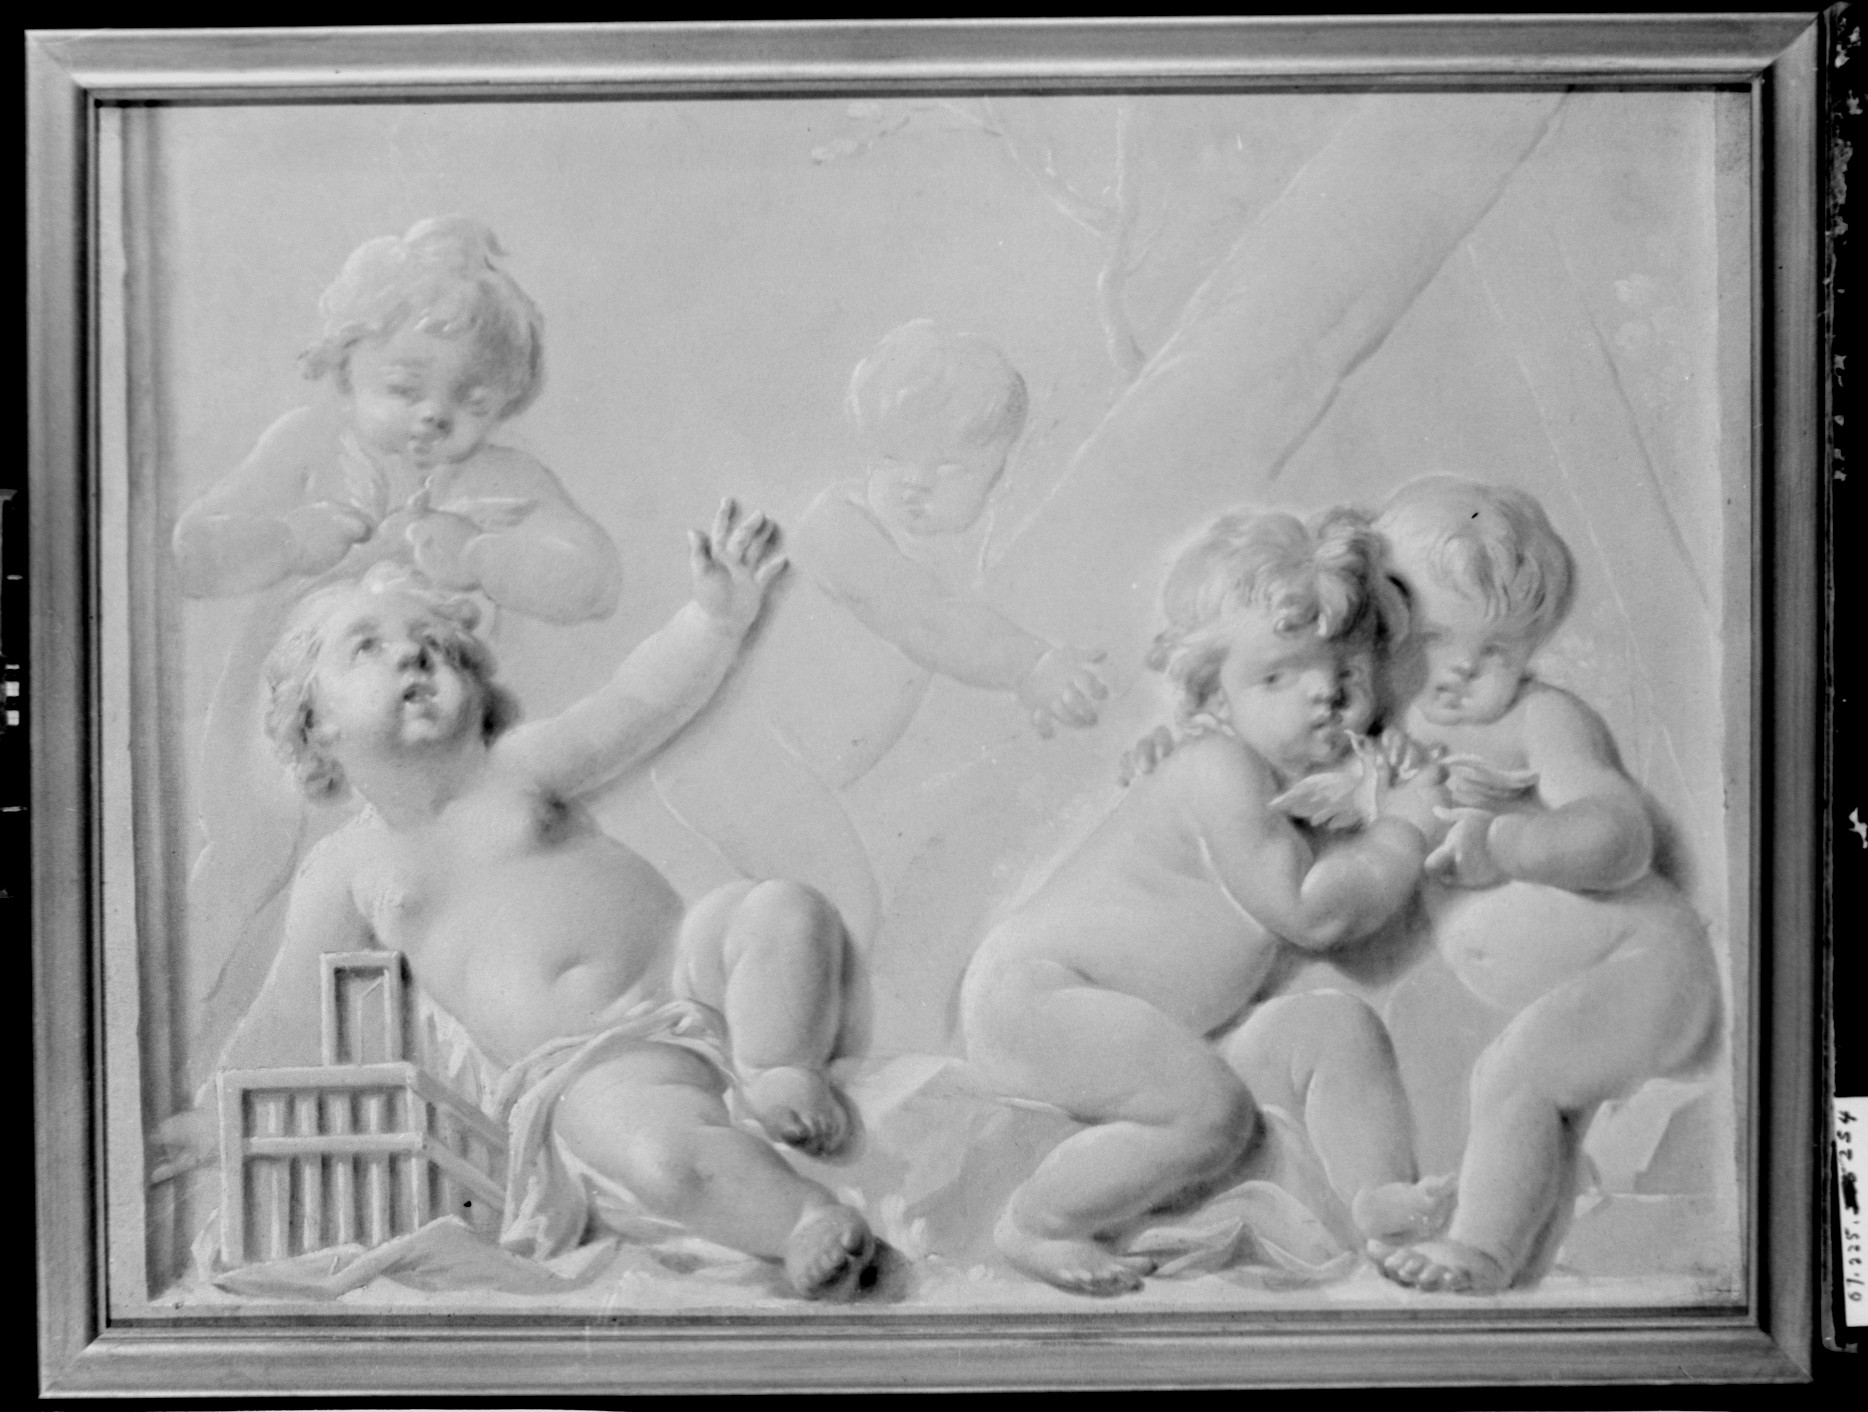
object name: overdoor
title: Putti with Birds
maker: piat joseph sauvage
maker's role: artist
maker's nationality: flemish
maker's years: 1744-1818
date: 1751-1800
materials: canvas, oil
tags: birds,putti